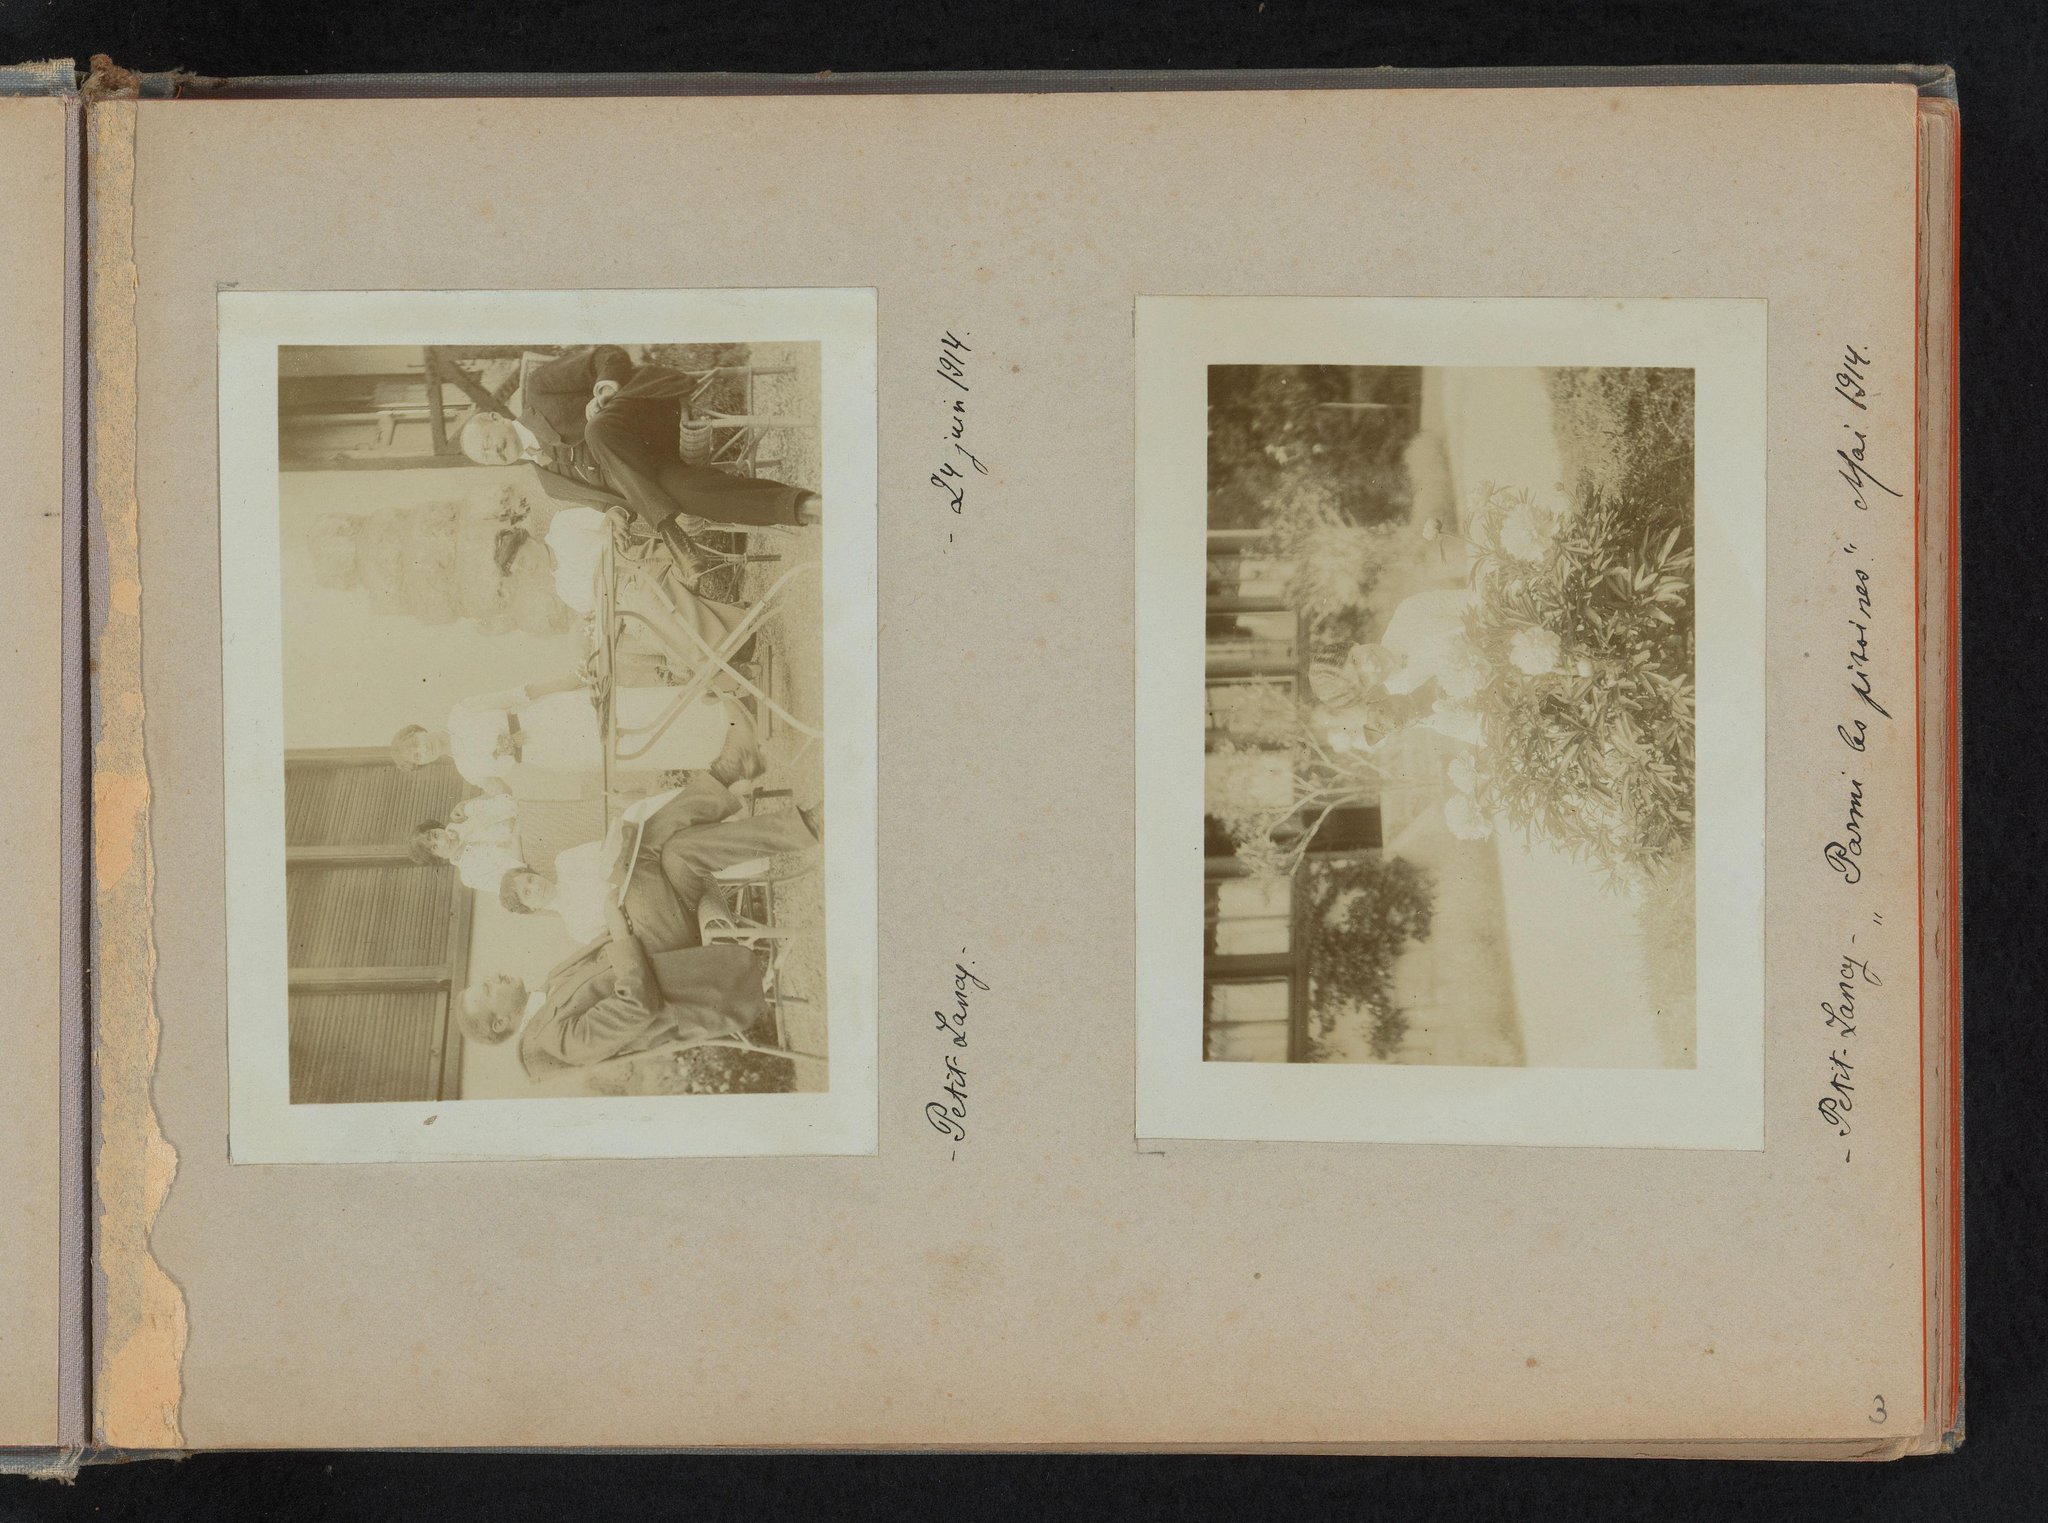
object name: photograph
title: Mensen op een terras en een vrouw met hond achter een struik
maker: Anonymous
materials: paper, cardboard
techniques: collodion silver print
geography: geneva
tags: historical persons, terrace, dog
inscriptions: inscription: ‘- 24 juin 1914.’, inscription: ‘- Petit-Lancy- "Parmi les pivoines." Mai 1914.’, inscription: ‘- Petit-Lancy.-’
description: Deze foto's maken deel uit van een album.